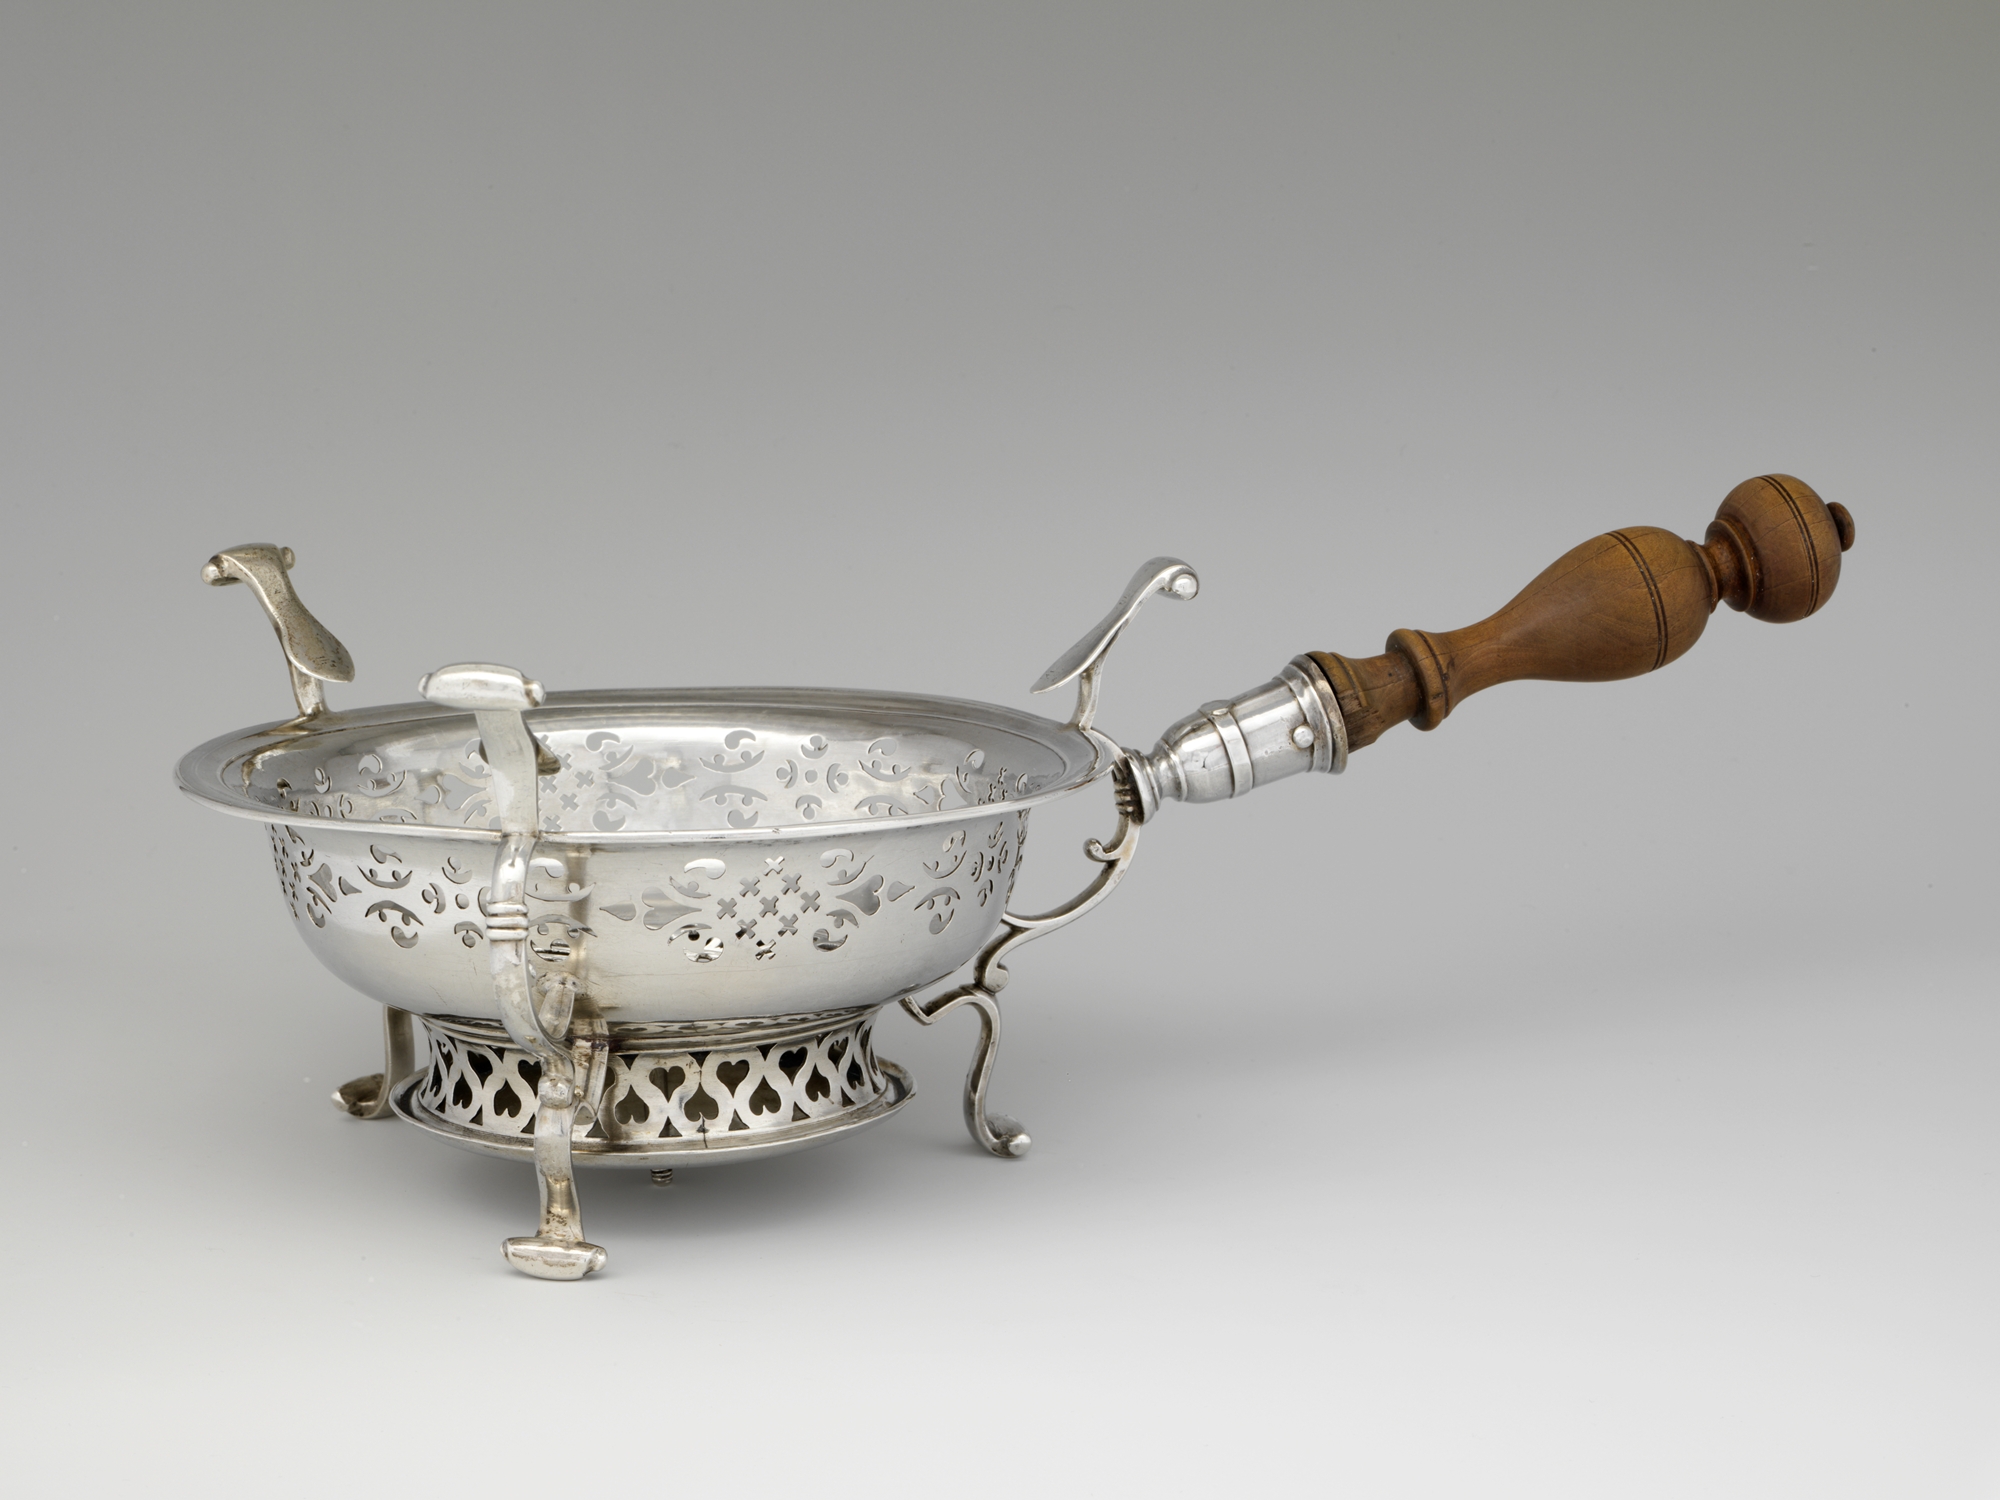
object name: chafing dish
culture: american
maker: john burt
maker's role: maker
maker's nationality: american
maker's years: 1692-1746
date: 1740-1745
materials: silver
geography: united states